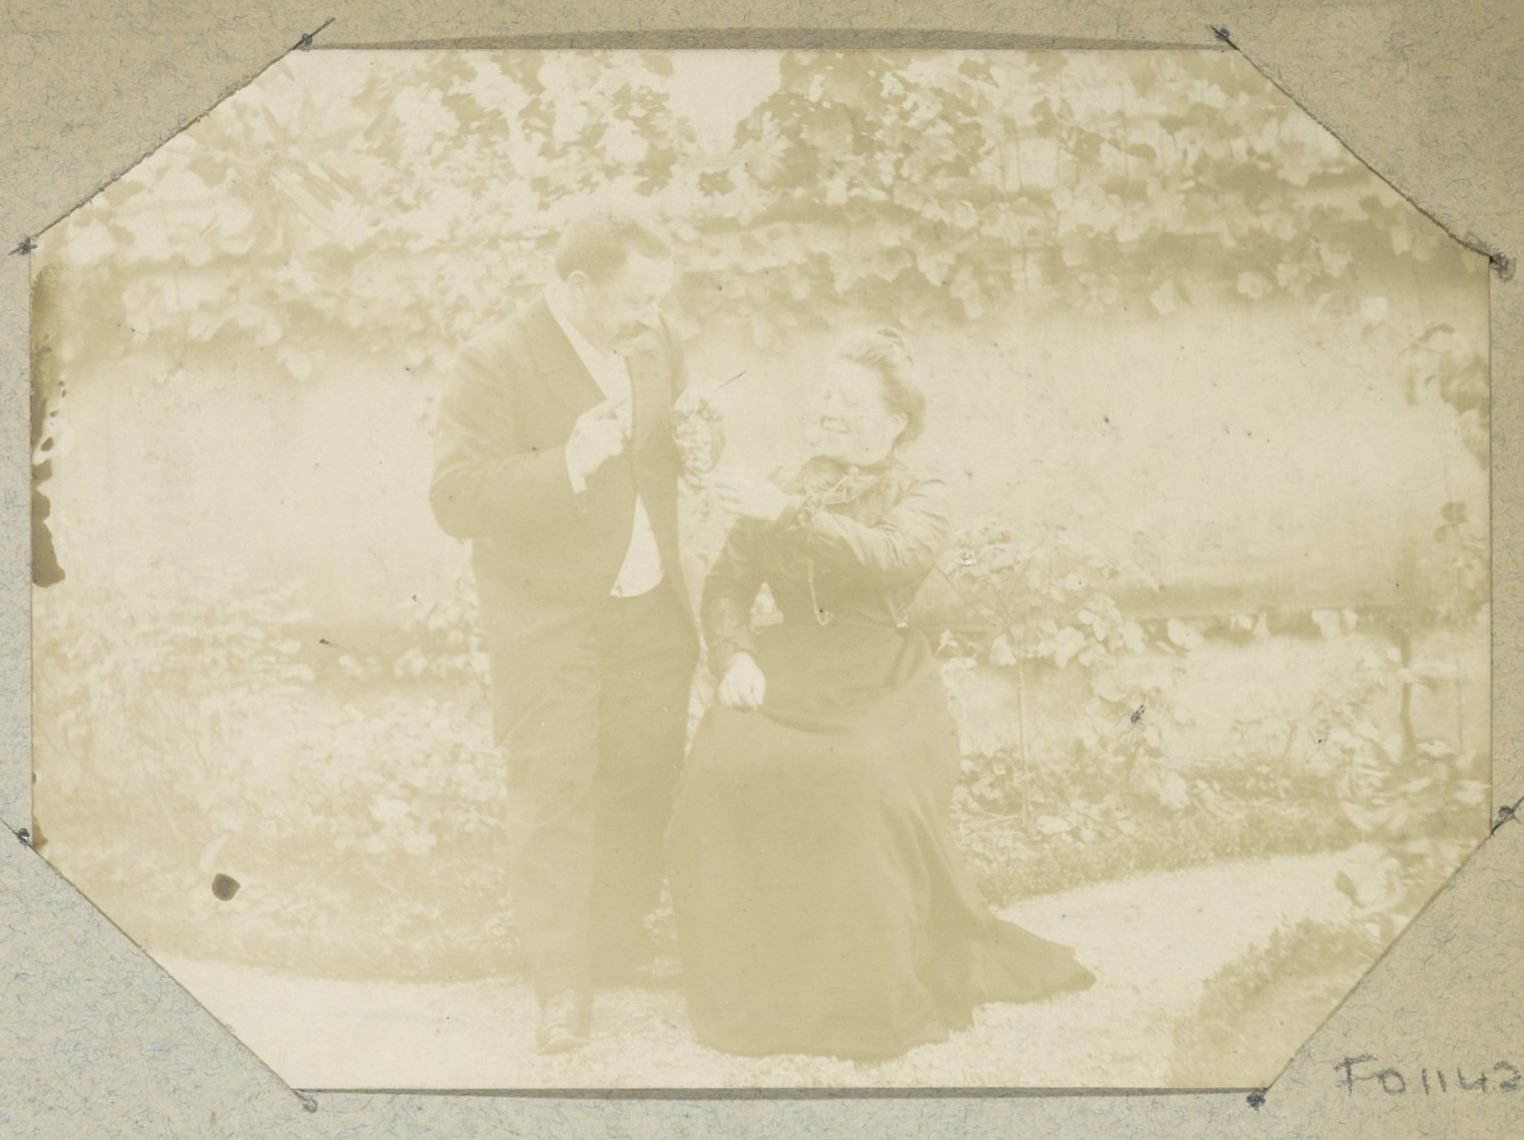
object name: photograph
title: Portret van een man en een vrouw in een tuin, vermoedelijk in Frankrijk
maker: Anonymous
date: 1890-1900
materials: paper, photographic support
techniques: daylight paper print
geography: france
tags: garden, marriage, married couple, 'matrimonium', france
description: Onderdeel van Album van een Franse amateur met foto's van Frankrijk, Algerije, Palmyra, de Wereldtentoonstelling van 1900 en van bekende Fransen.